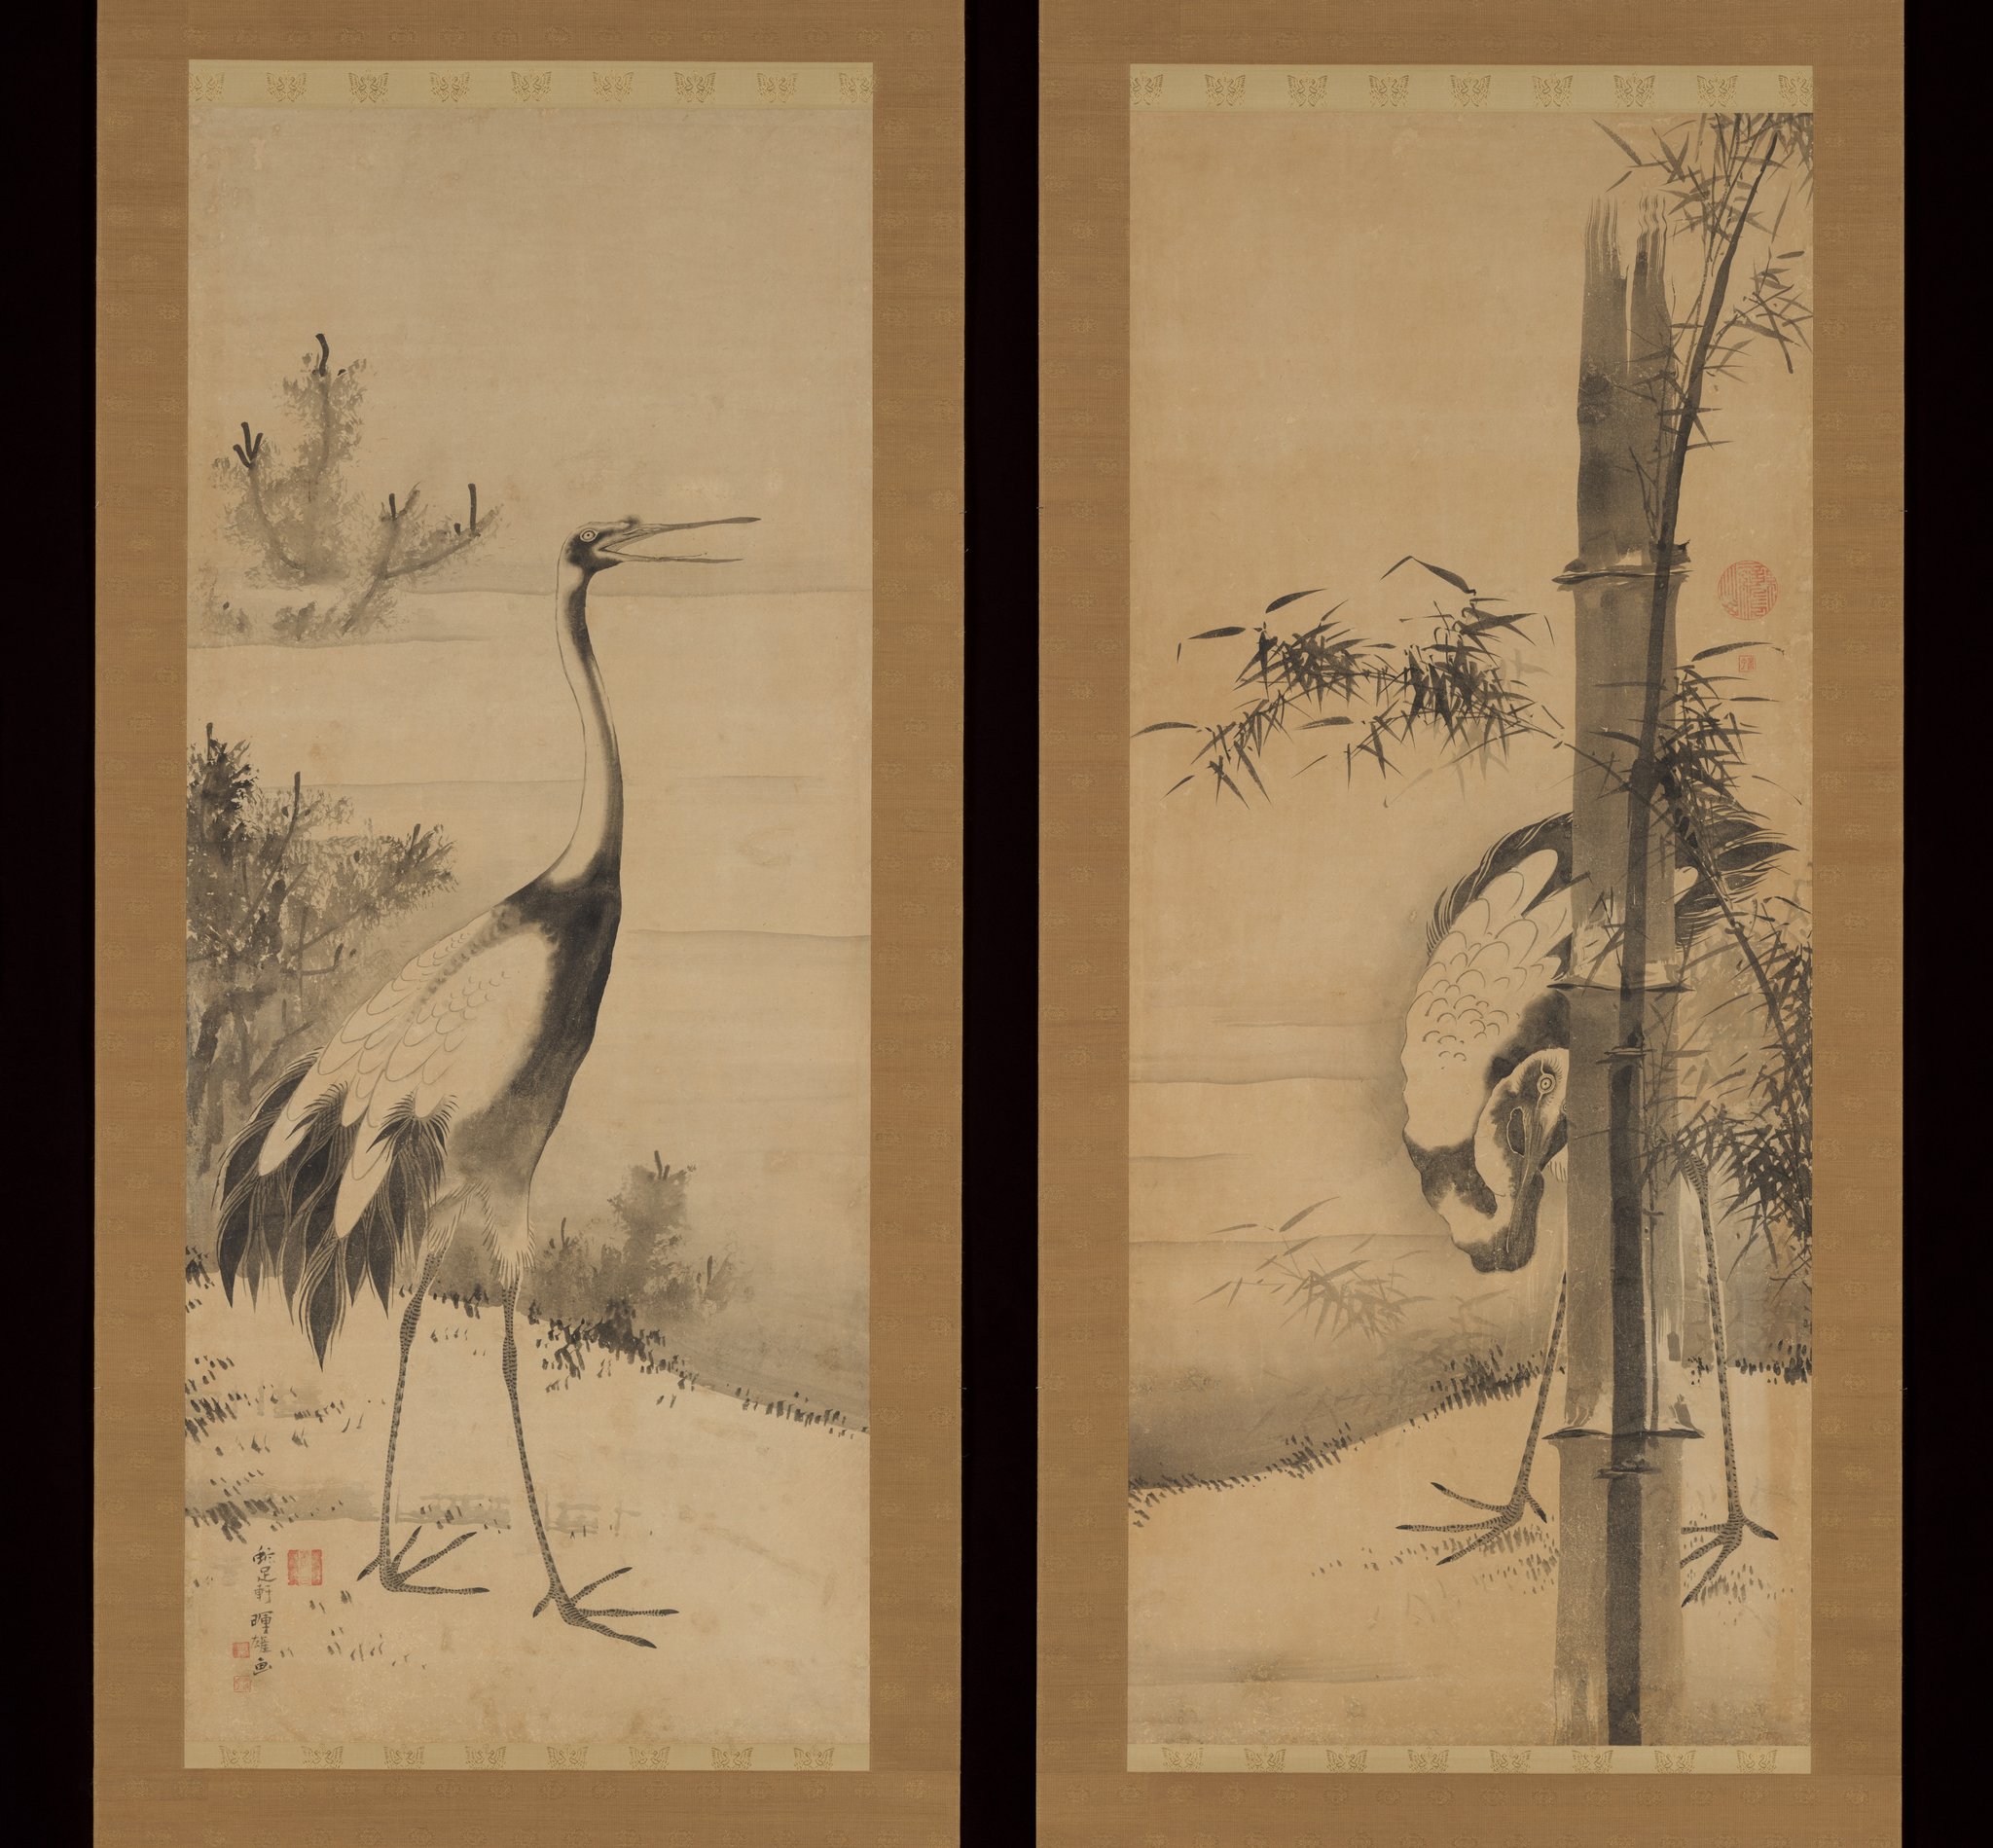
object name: hanging scroll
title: Cranes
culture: japanese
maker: soga shōhaku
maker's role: artist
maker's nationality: japanese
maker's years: 1730-1781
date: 1760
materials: ink, paper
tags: cranes